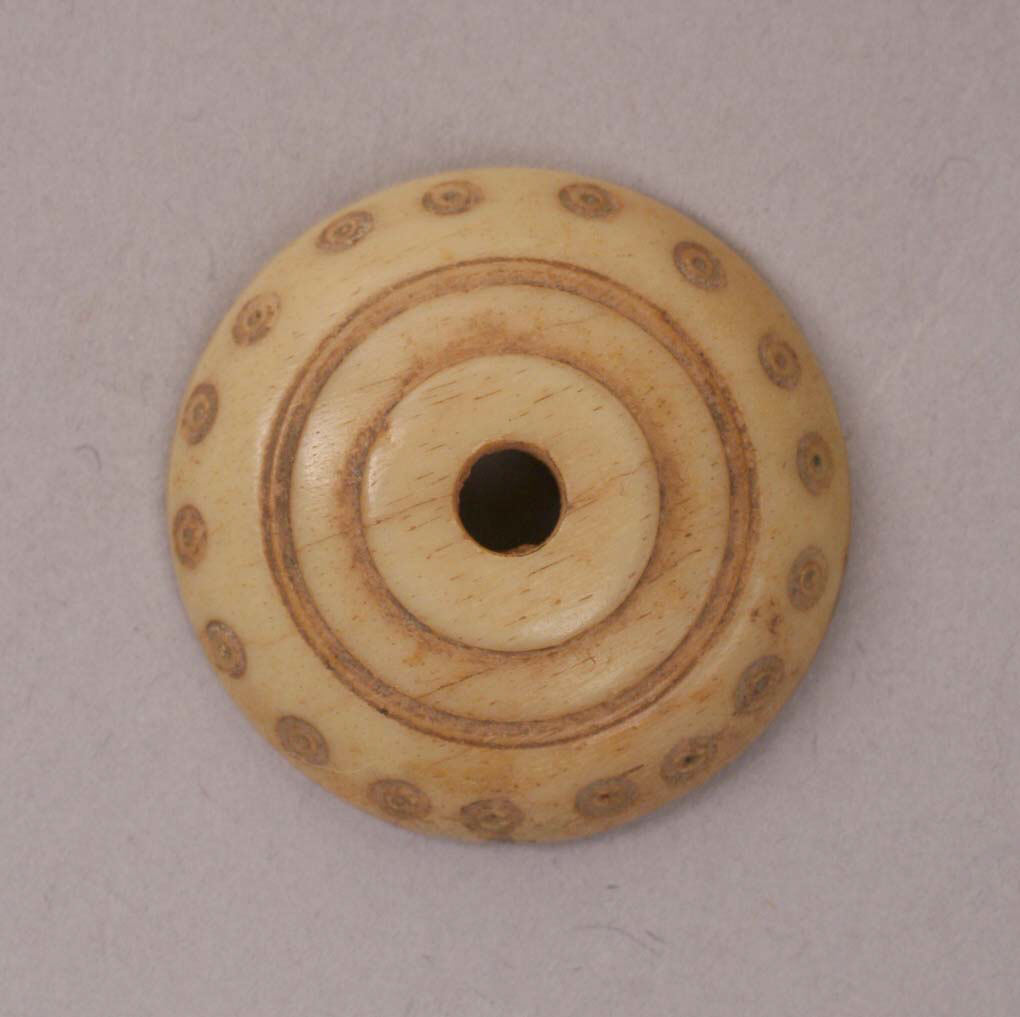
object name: button or bead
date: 801-1000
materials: bone, paint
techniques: incising, inlay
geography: iran